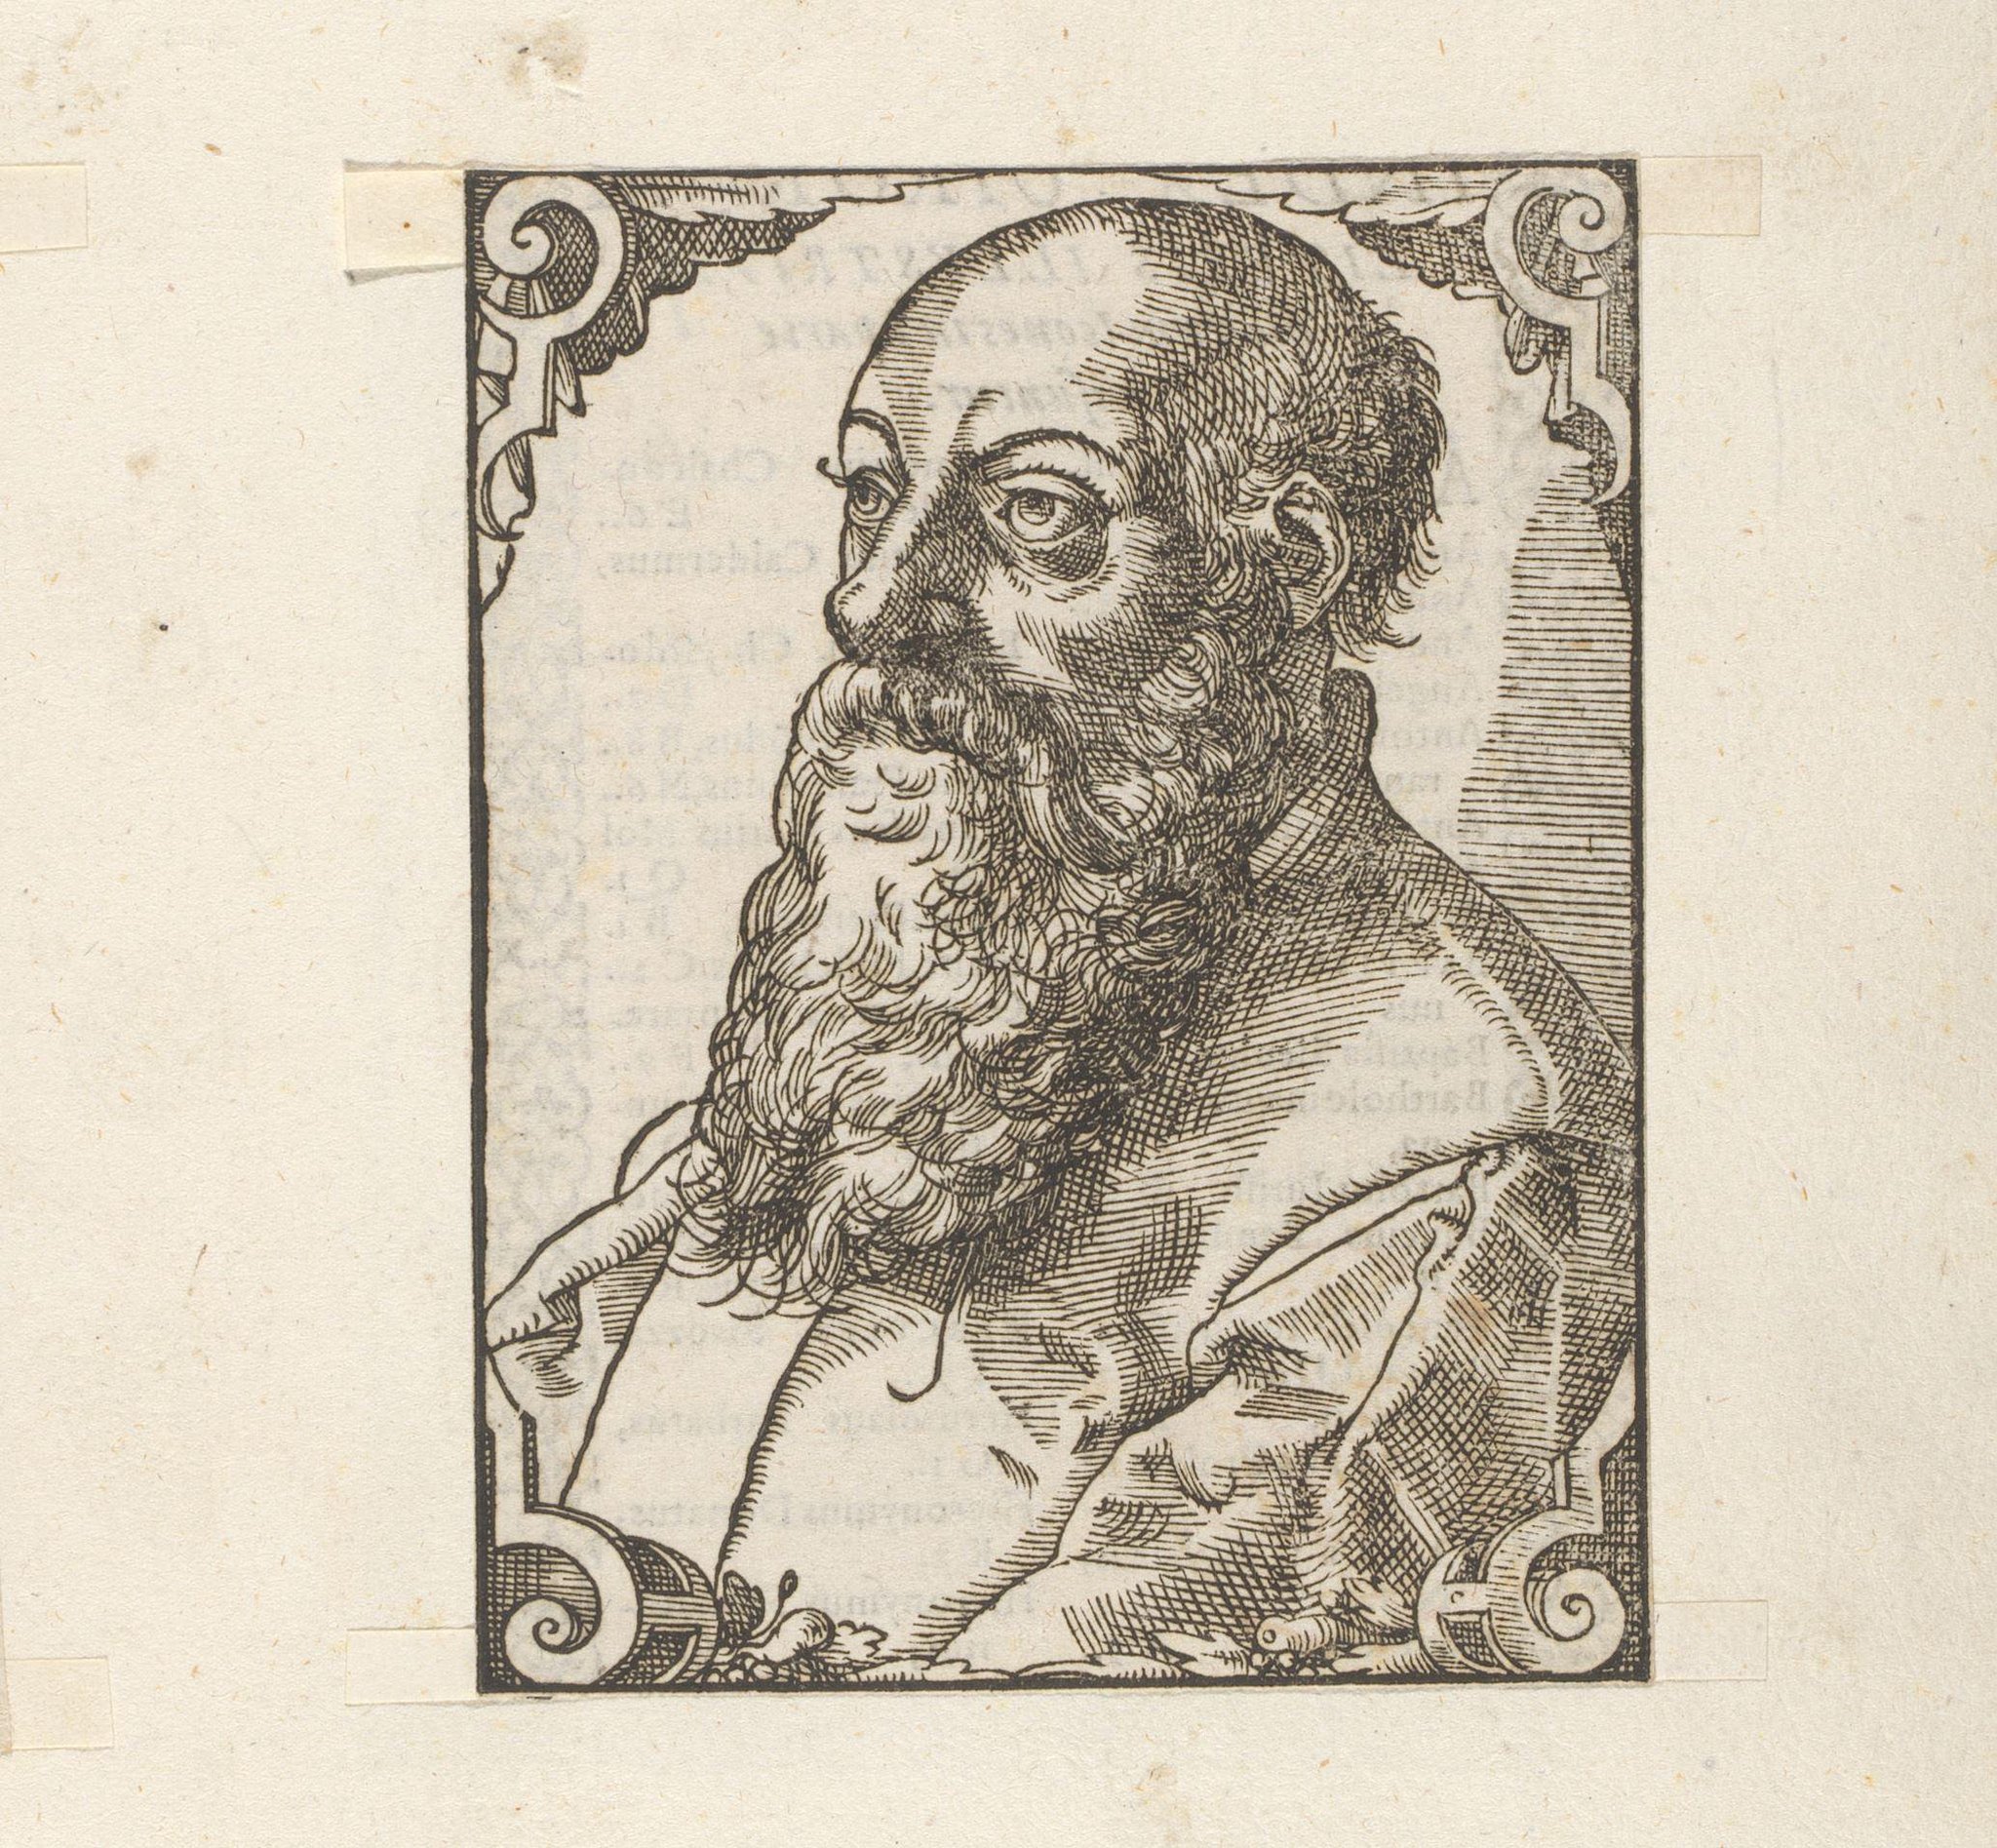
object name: album leaf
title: Portret van Florentinus Gellus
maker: Anonymous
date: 1549-1584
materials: paper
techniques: letterpress printing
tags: historical persons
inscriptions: collector's mark: Lugt 240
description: Prent gebruikt in: Reusner, Nikolaus. Icones Sive Imagines Vivae. Bazel: Conrad Waldkirch, 1589.